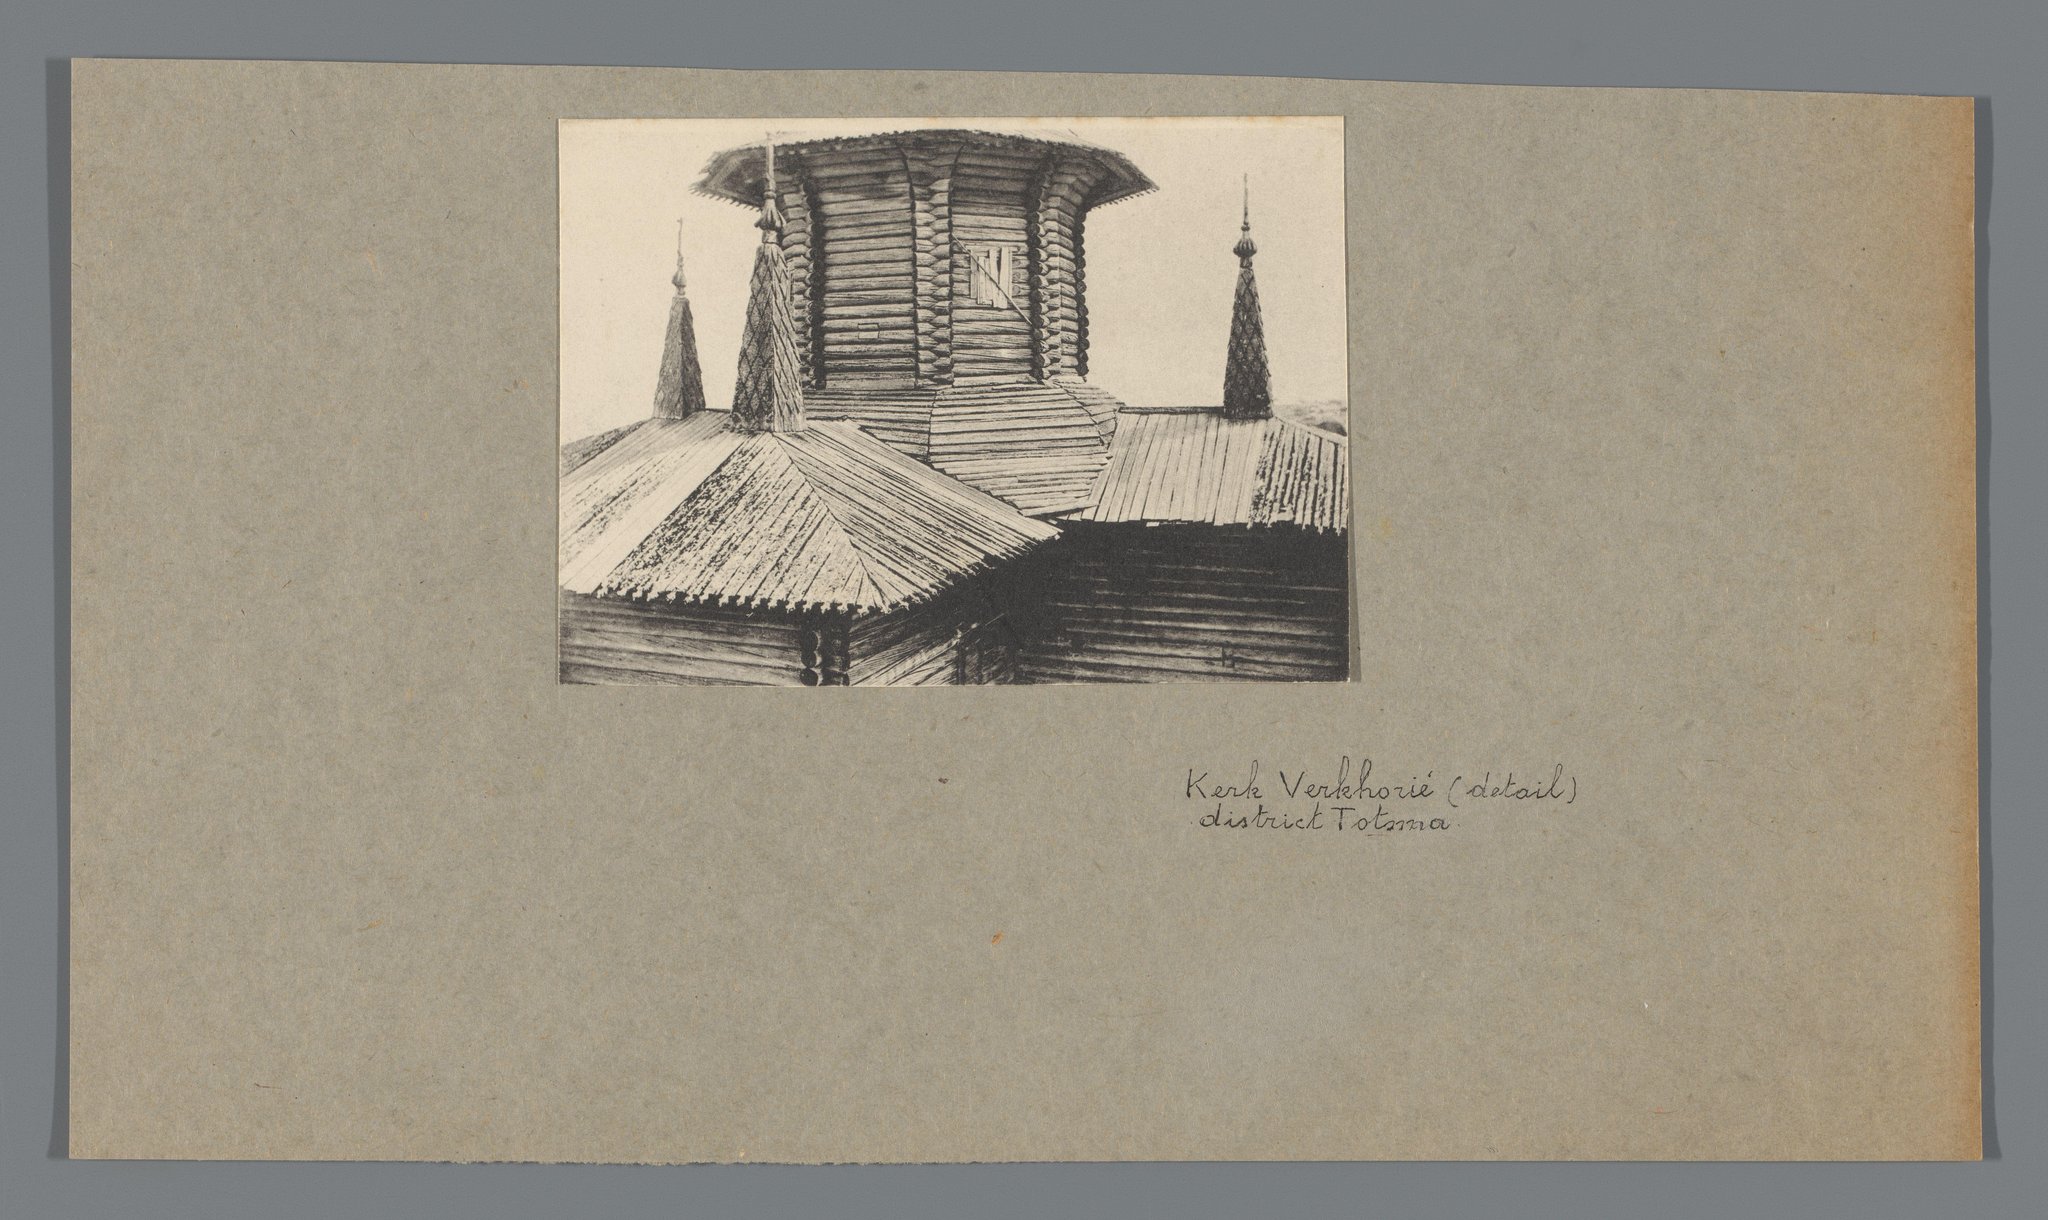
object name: photograph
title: Kerk Verkhorie (detail)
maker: Anonymous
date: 1860-1925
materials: photographic support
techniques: photograph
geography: russia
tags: russia